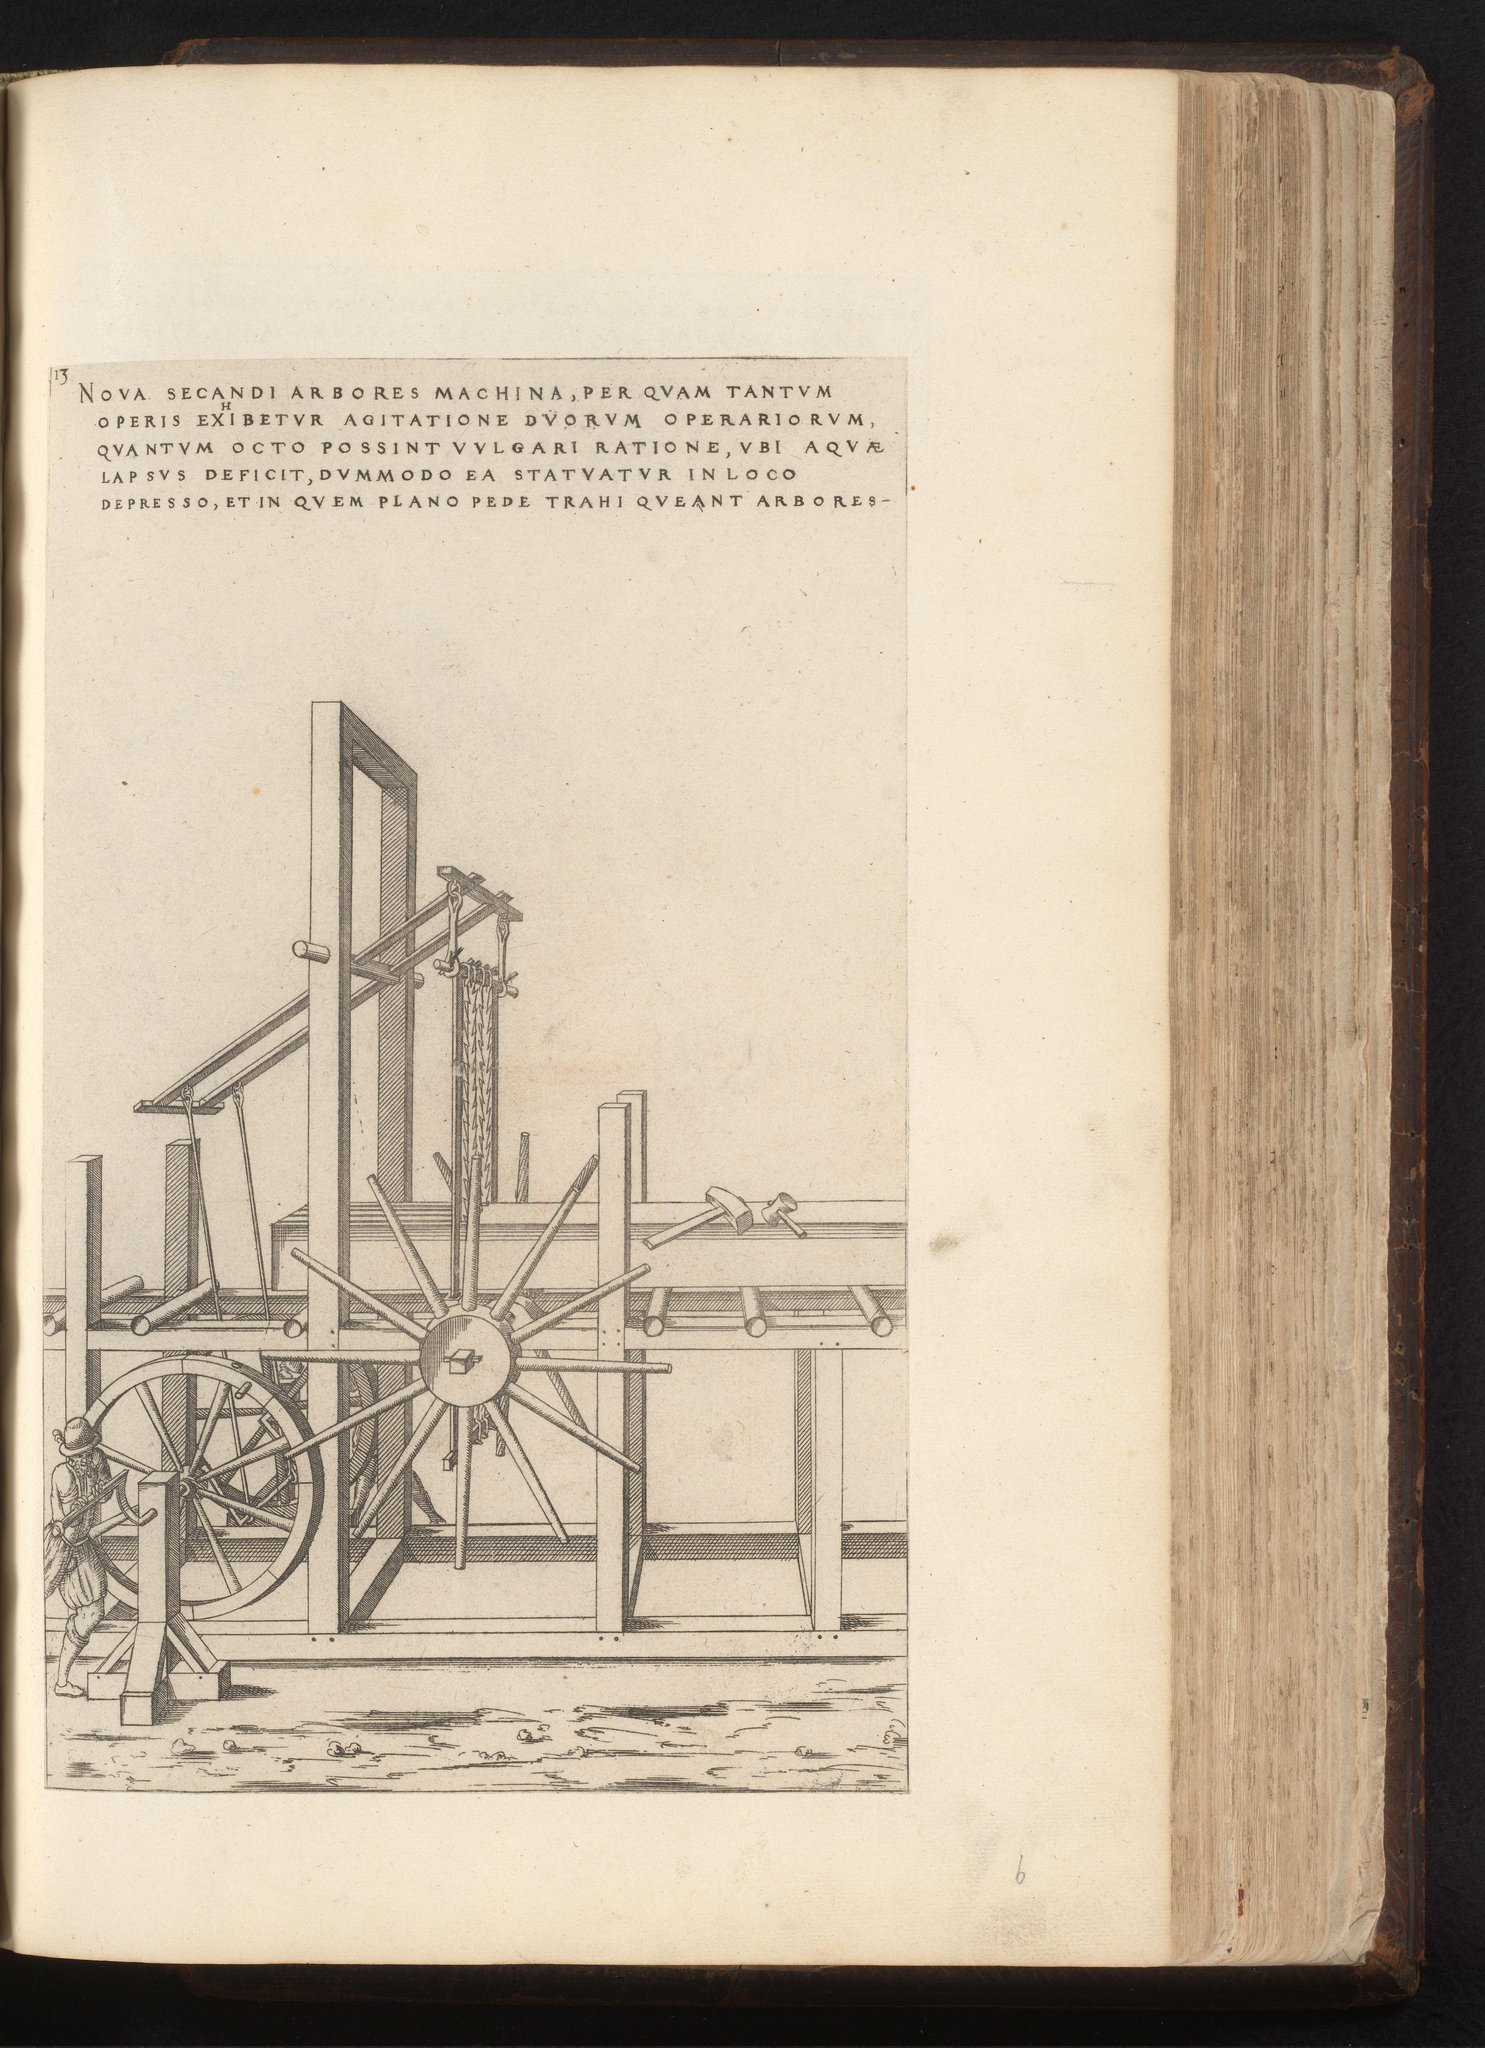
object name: album leaf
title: Werker aan een zaagmachine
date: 1579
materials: paper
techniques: etching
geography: lyon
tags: industries ~ wood, sawing (industrial process)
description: Prent uit: Besson, Jacques. Theatre des instrumens mathematiques & mechaniques. Lyon: Barthelemy Vincent, 1579. Prent voor het eerst verschenen in de eerste editie van ca. 1569.